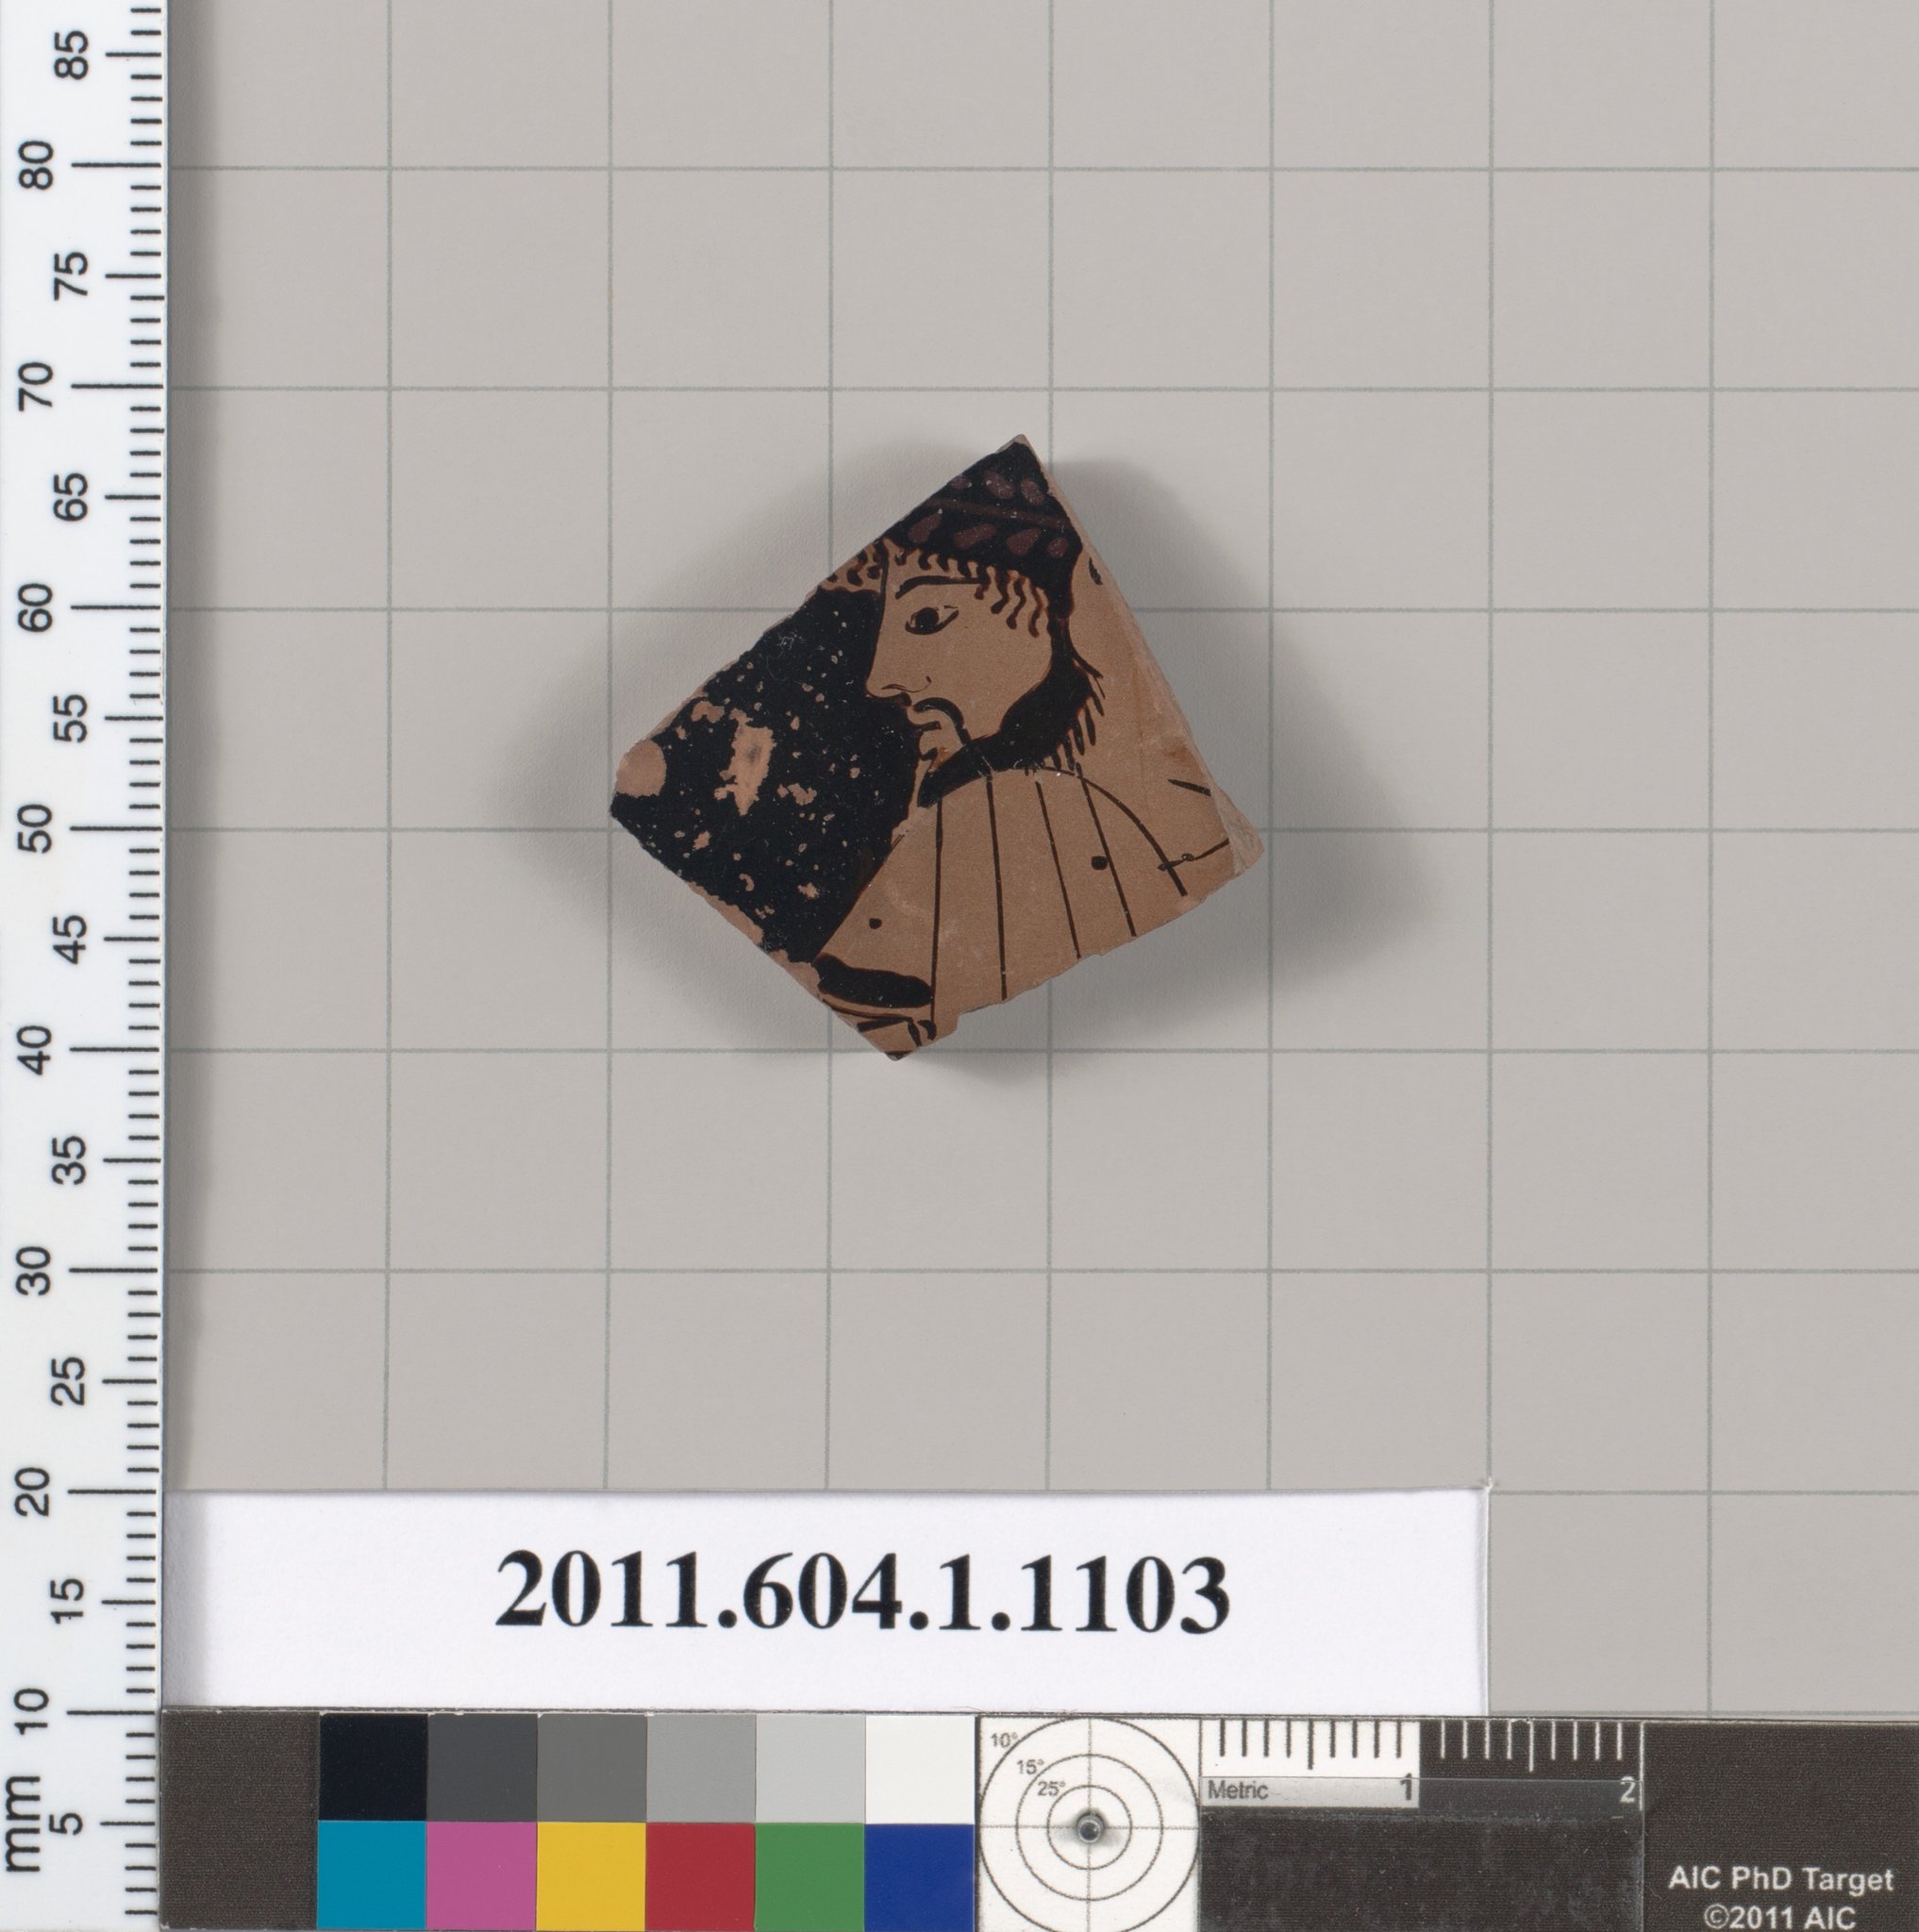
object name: kylix fragment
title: Terracotta fragment of a kylix (drinking cup)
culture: greek, attic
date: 490-480 BCE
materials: terracotta